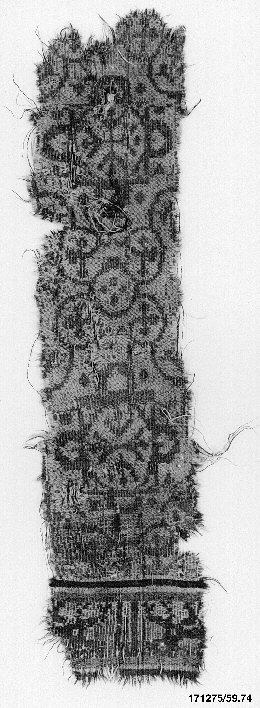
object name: textile fragment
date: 701-800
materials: wool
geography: egypt